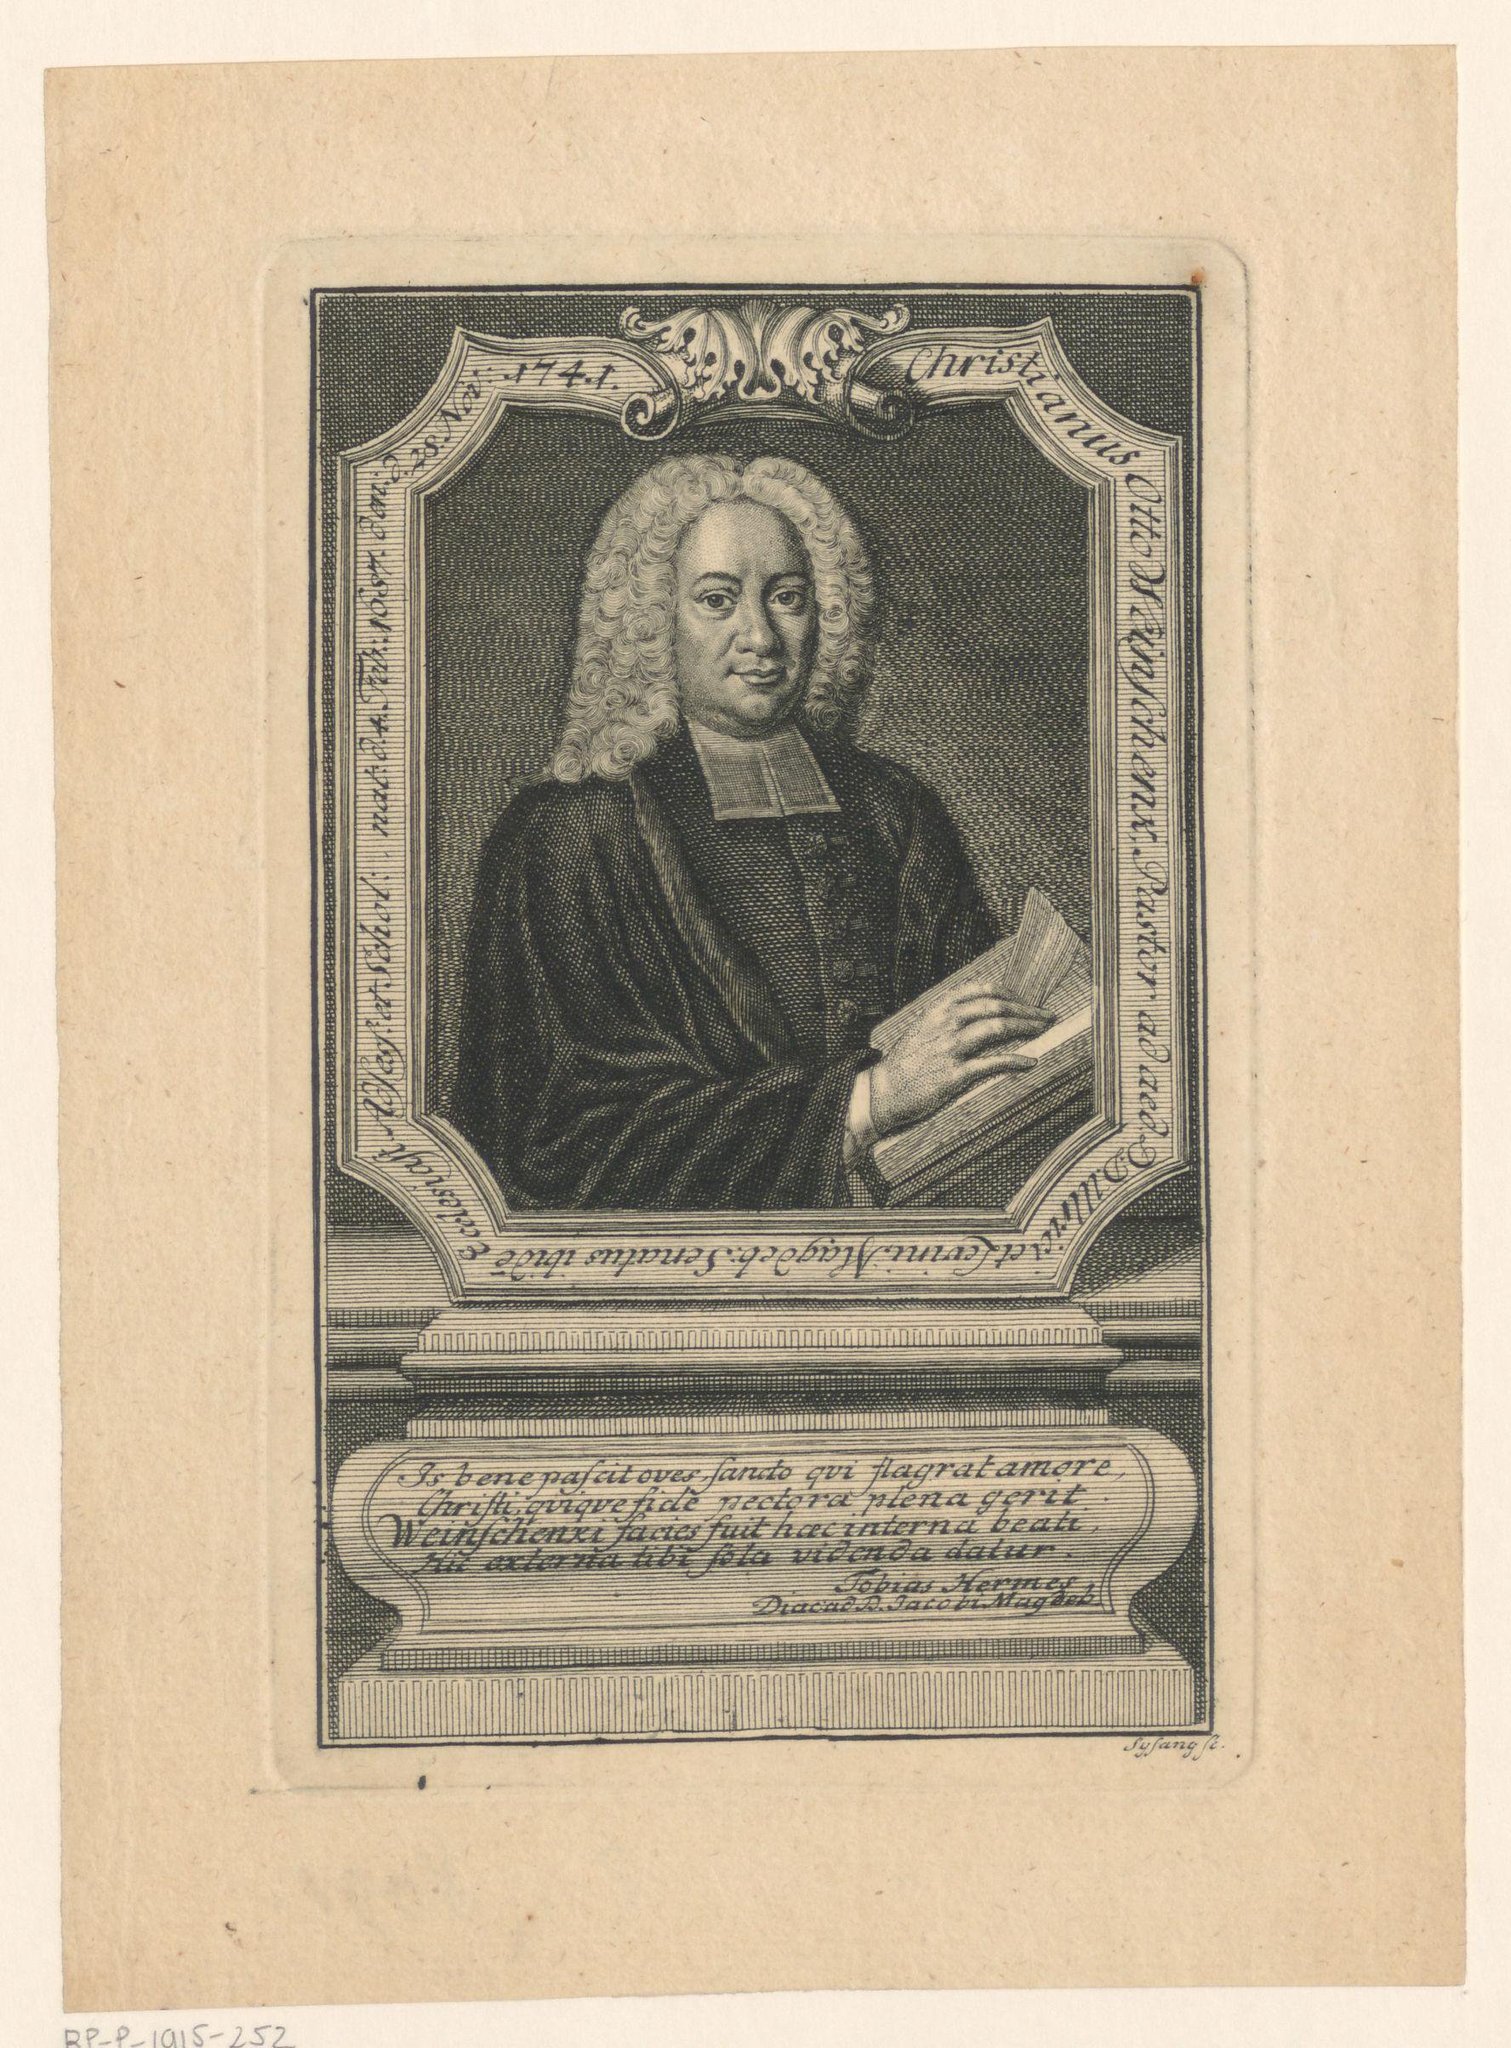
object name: print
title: Portret van Christian Otto Weinschenk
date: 1741-1757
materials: paper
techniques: engraving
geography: leipzig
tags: historical persons, book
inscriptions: collector's mark: Lugt 2228, number: ‘2.8091’, collector's mark: Lugt 358